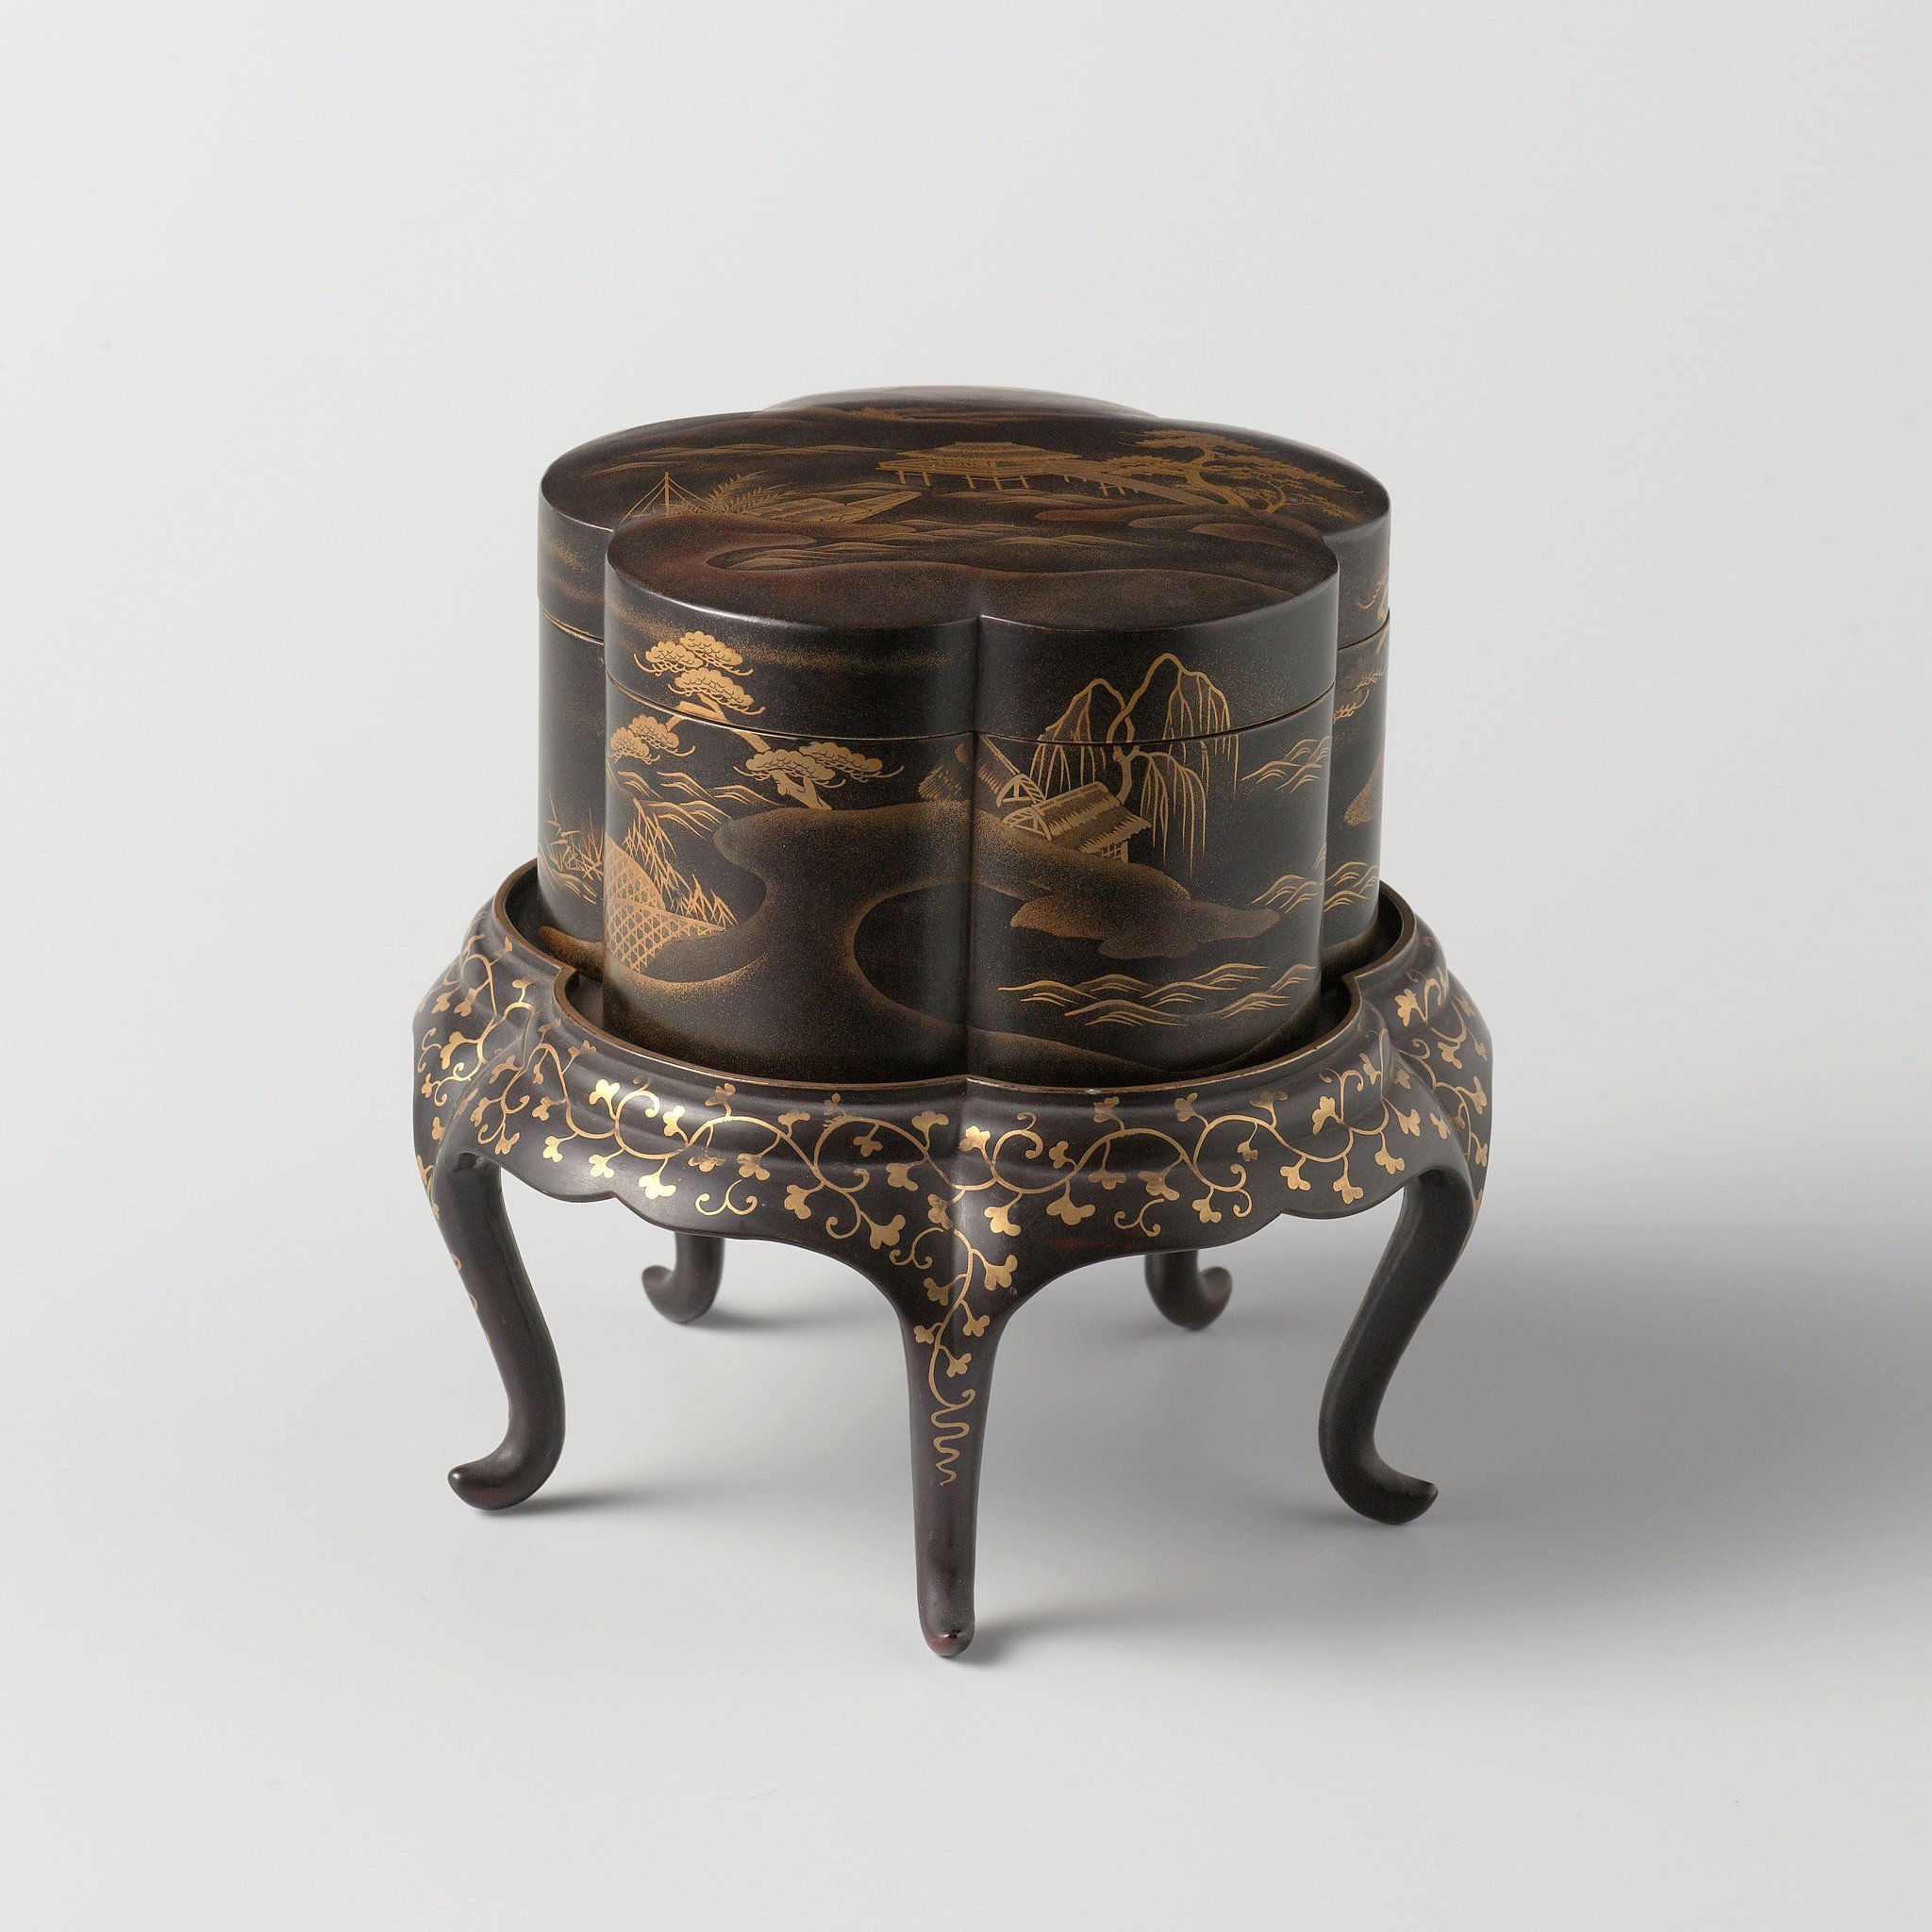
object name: foot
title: Voet, met vergulde landschappen op zwarte grond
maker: Anonymous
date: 1700-1800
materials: gold, lacquer, wood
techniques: lacquer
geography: japan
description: Losse voet met gebogen poten. Zwarte lak met decoraties in hiramakie met waterlandschapjes, vlinders en bloemen. Bladranken op de poten.